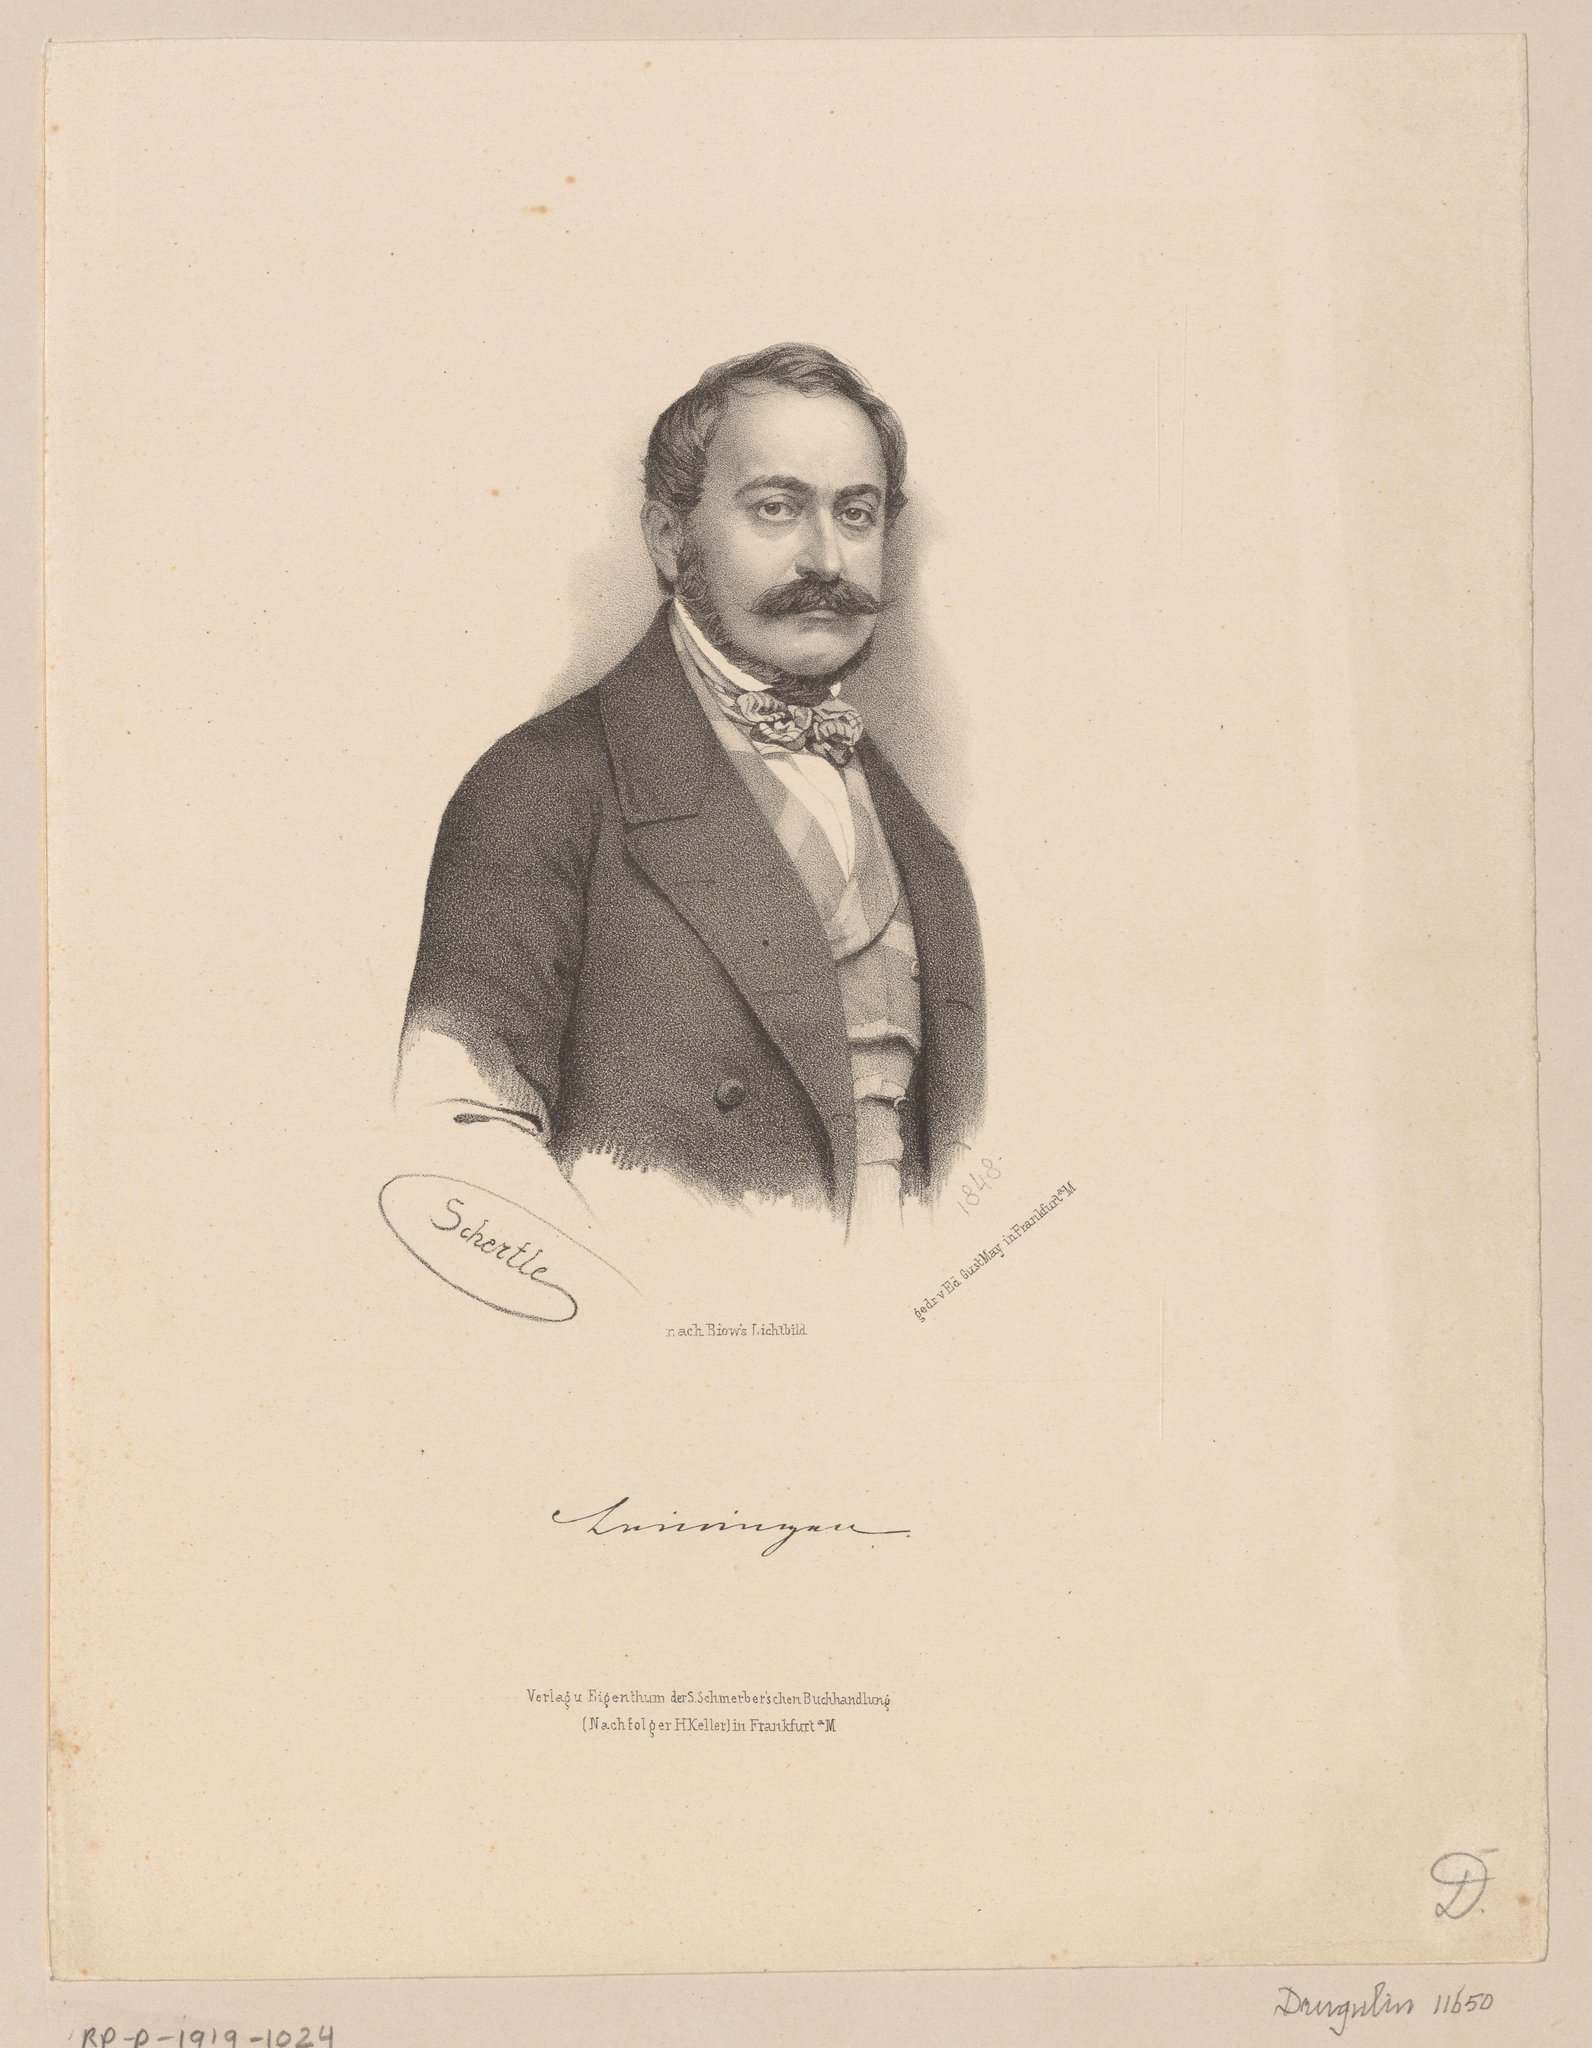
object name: print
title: Portretten van Duitse mannen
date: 1848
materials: paper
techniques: lithograph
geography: frankfurt am main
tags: historical persons, politician, e.g. party leader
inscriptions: collector's mark: Lugt 2228